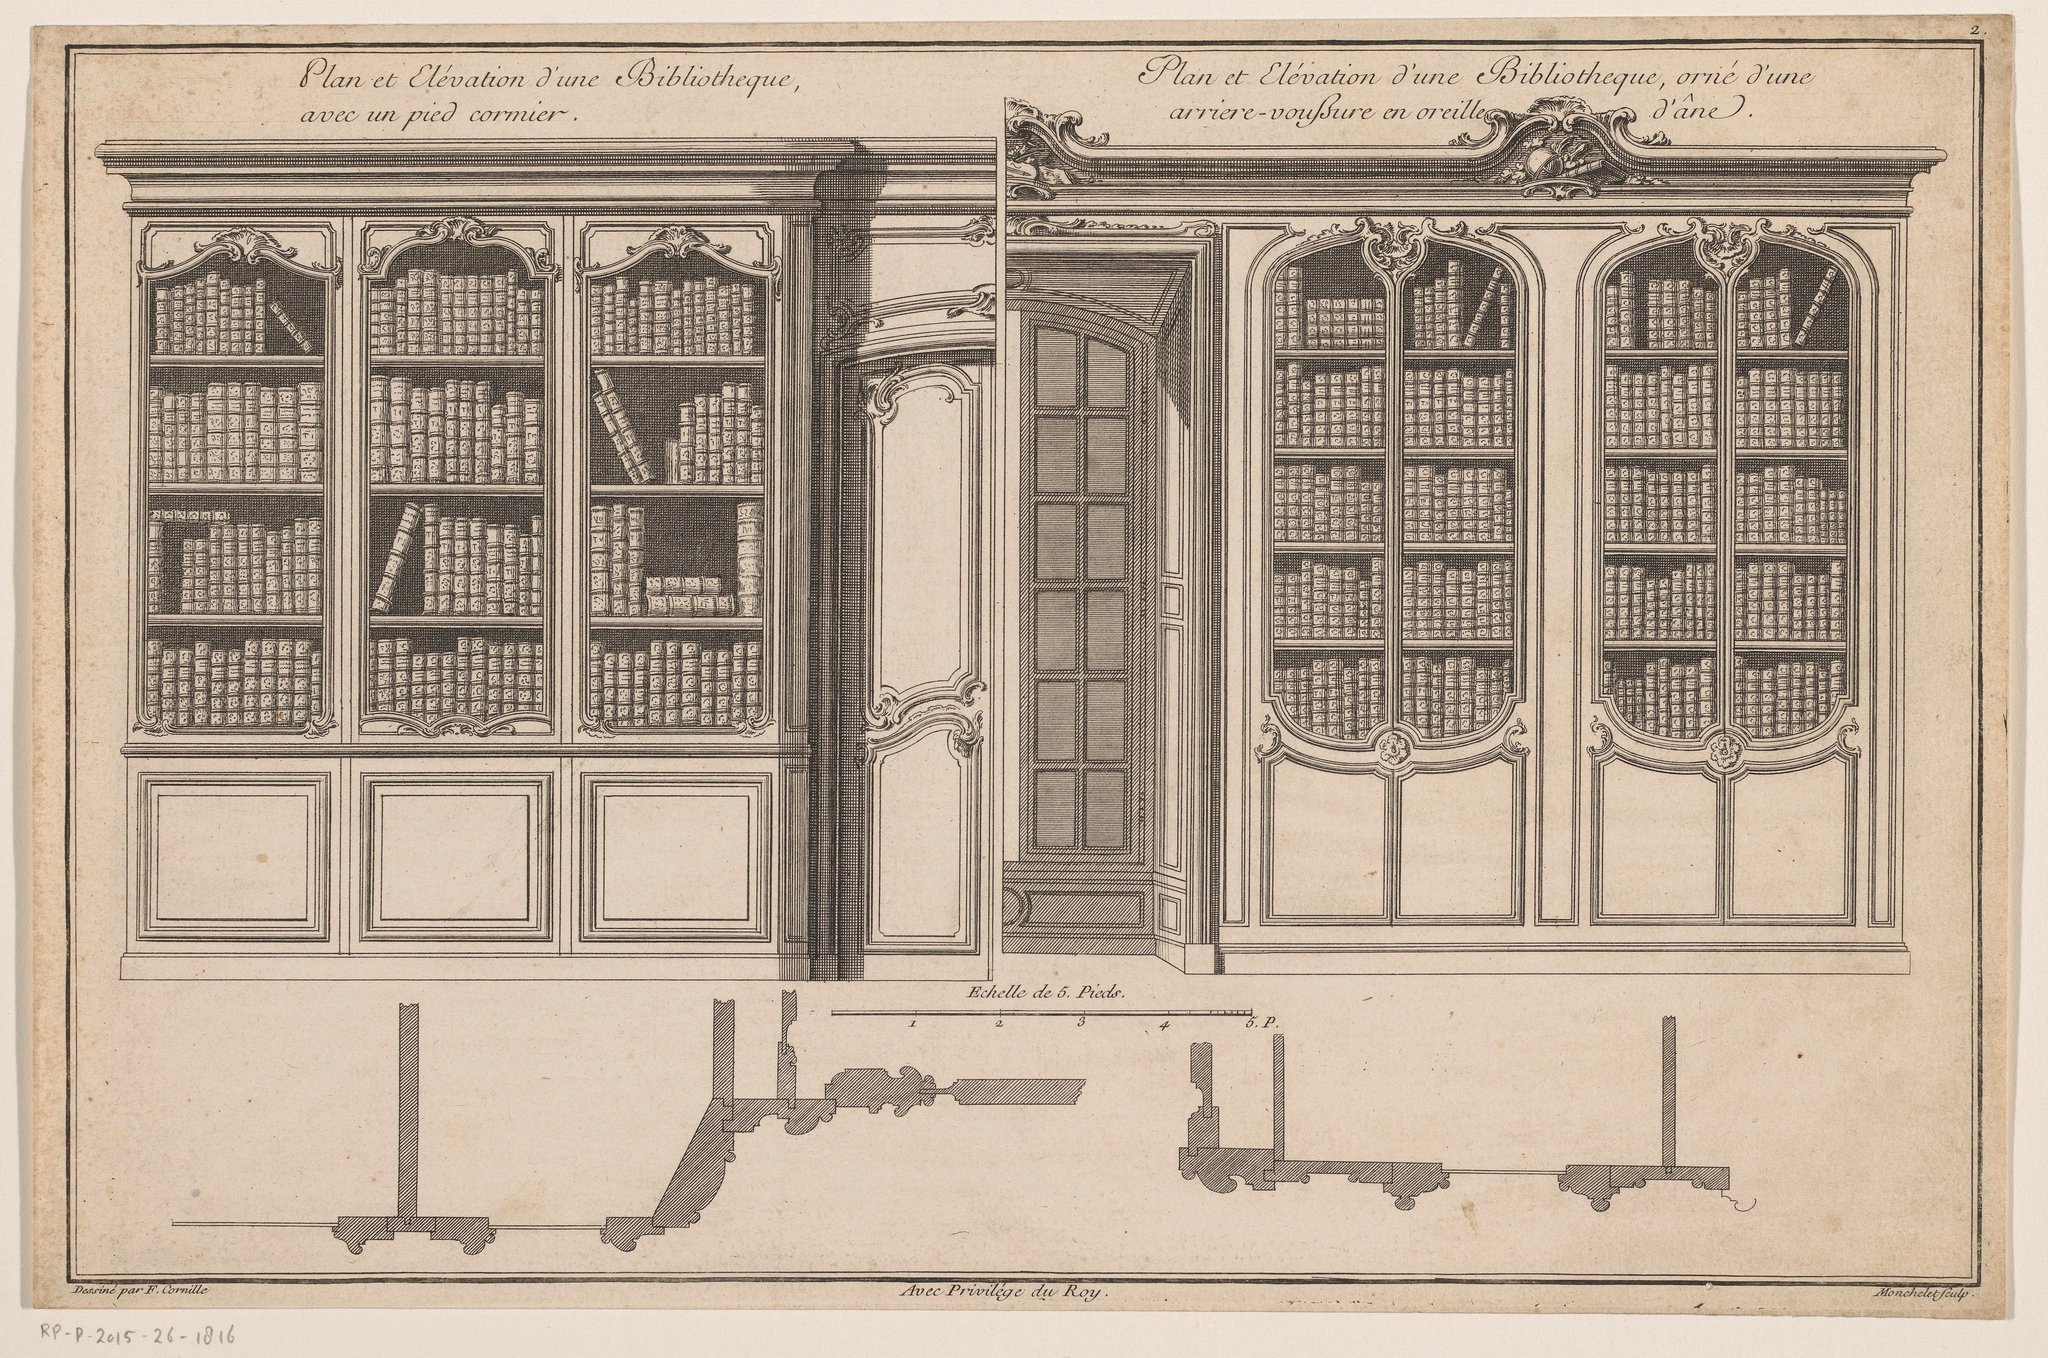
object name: print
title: Plan et elévation d'une bibliotheque, avec un pied cormier / Plan et elévation d'une bibliotheque, orné d'une arriere-vousure en oreille d'âne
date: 1740-1765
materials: paper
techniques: etching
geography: paris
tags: bookshelves, door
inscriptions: collector's mark: Lugt 2228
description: Linksboven genummerd: Liv. 9. Rechtsboven genummerd: 2.